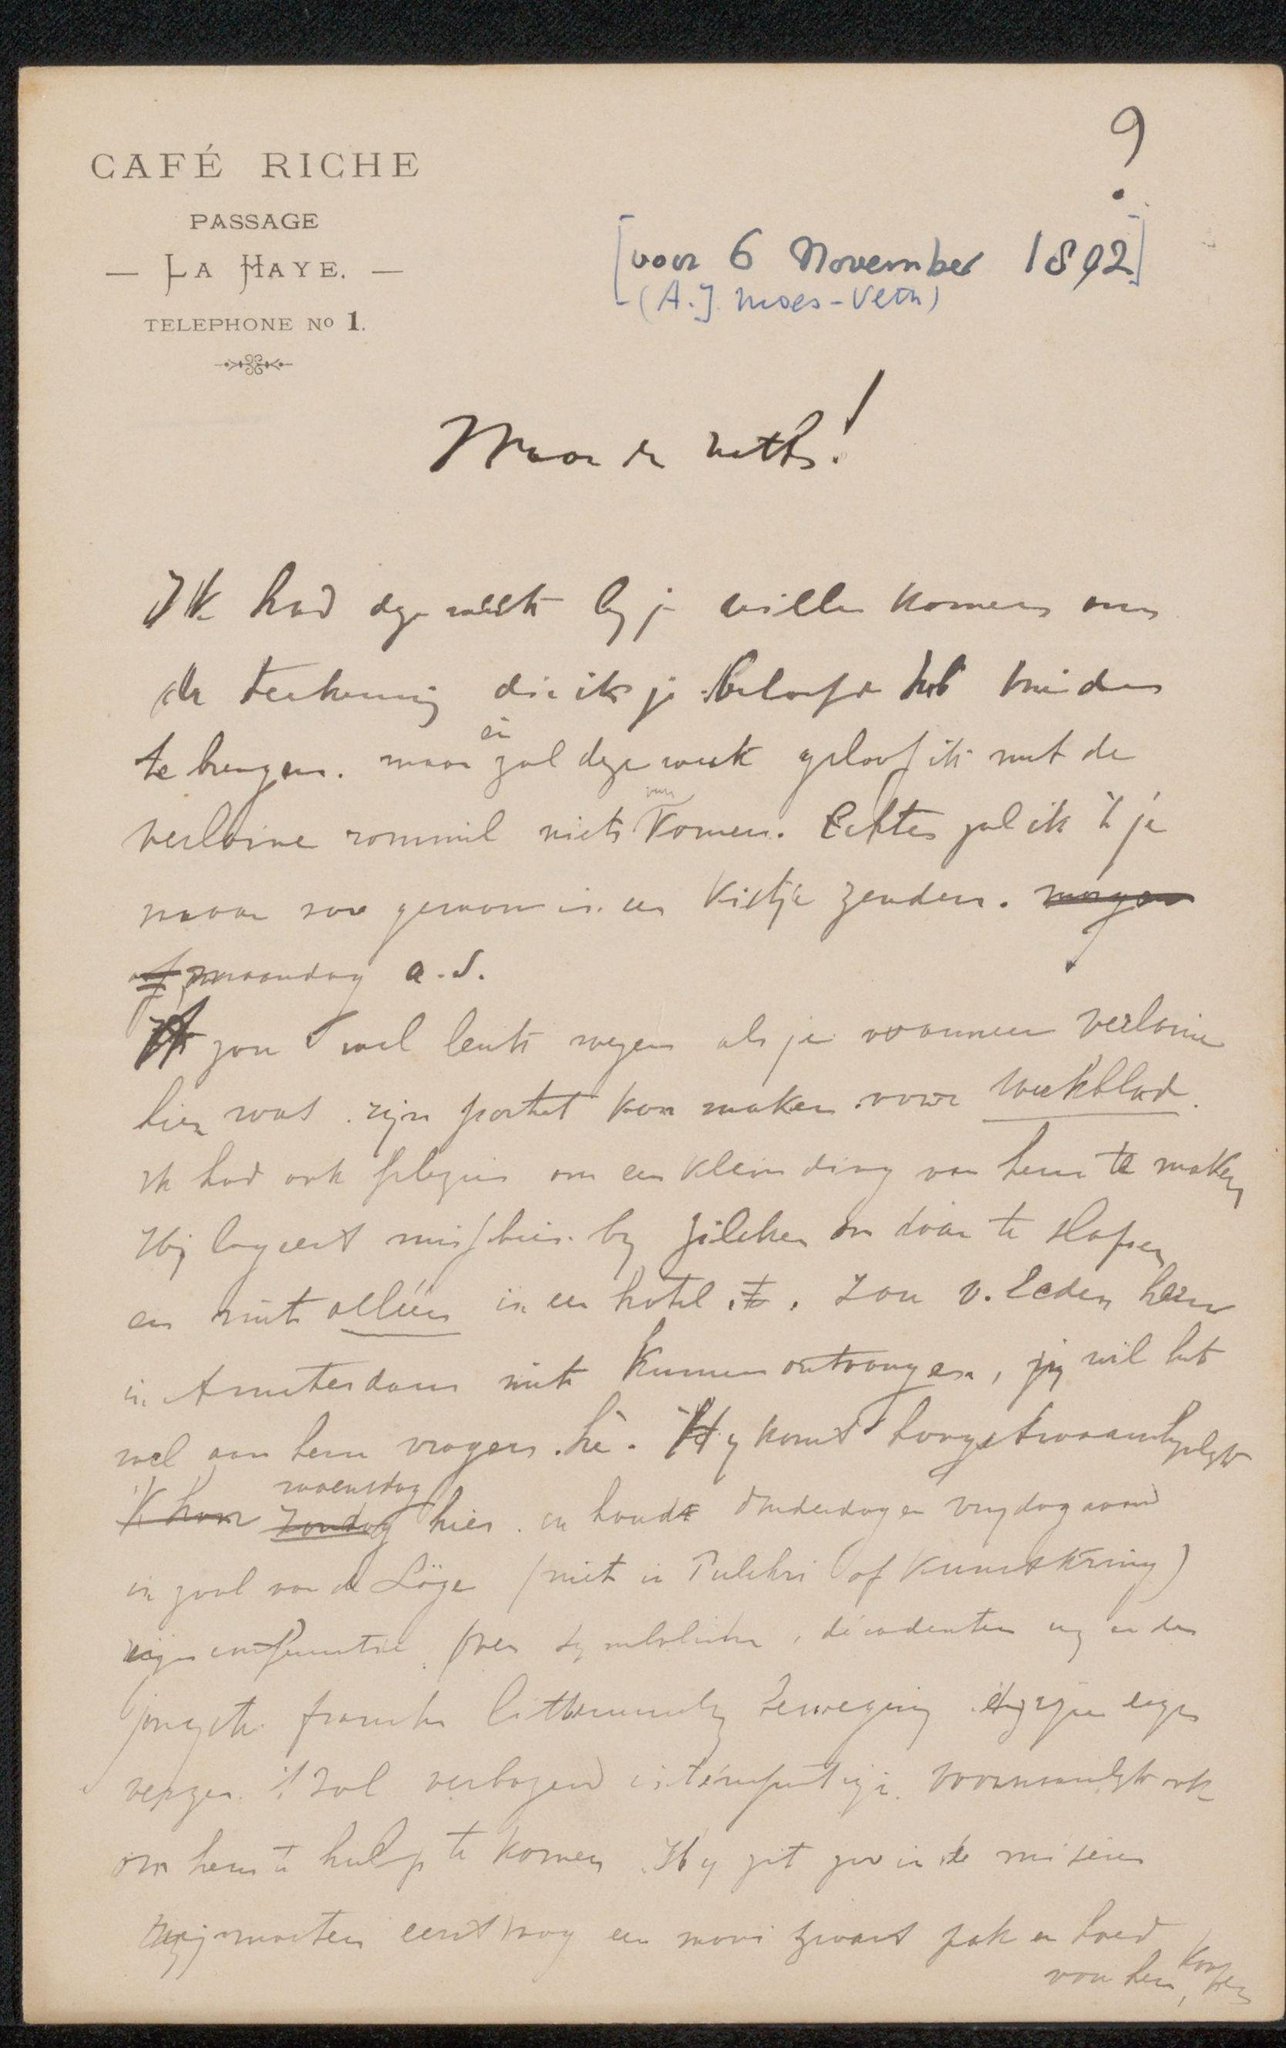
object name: letter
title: Brief aan Jan Veth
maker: jan toorop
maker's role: draughtsman, painter, print maker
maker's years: 1858-1928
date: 1874-1925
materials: ink, paper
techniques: pen, printing, writing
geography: the hague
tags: dordrecht, amsterdam, designer, jan veth, paris, paul verlaine, haarlem, frederik van eeden, philip zilcken, drawing, historical persons (portraits and scenes from the life)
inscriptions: collector's mark: ‘RPK’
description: Brief gedateerd voor 6 November 1892 in latere hand.